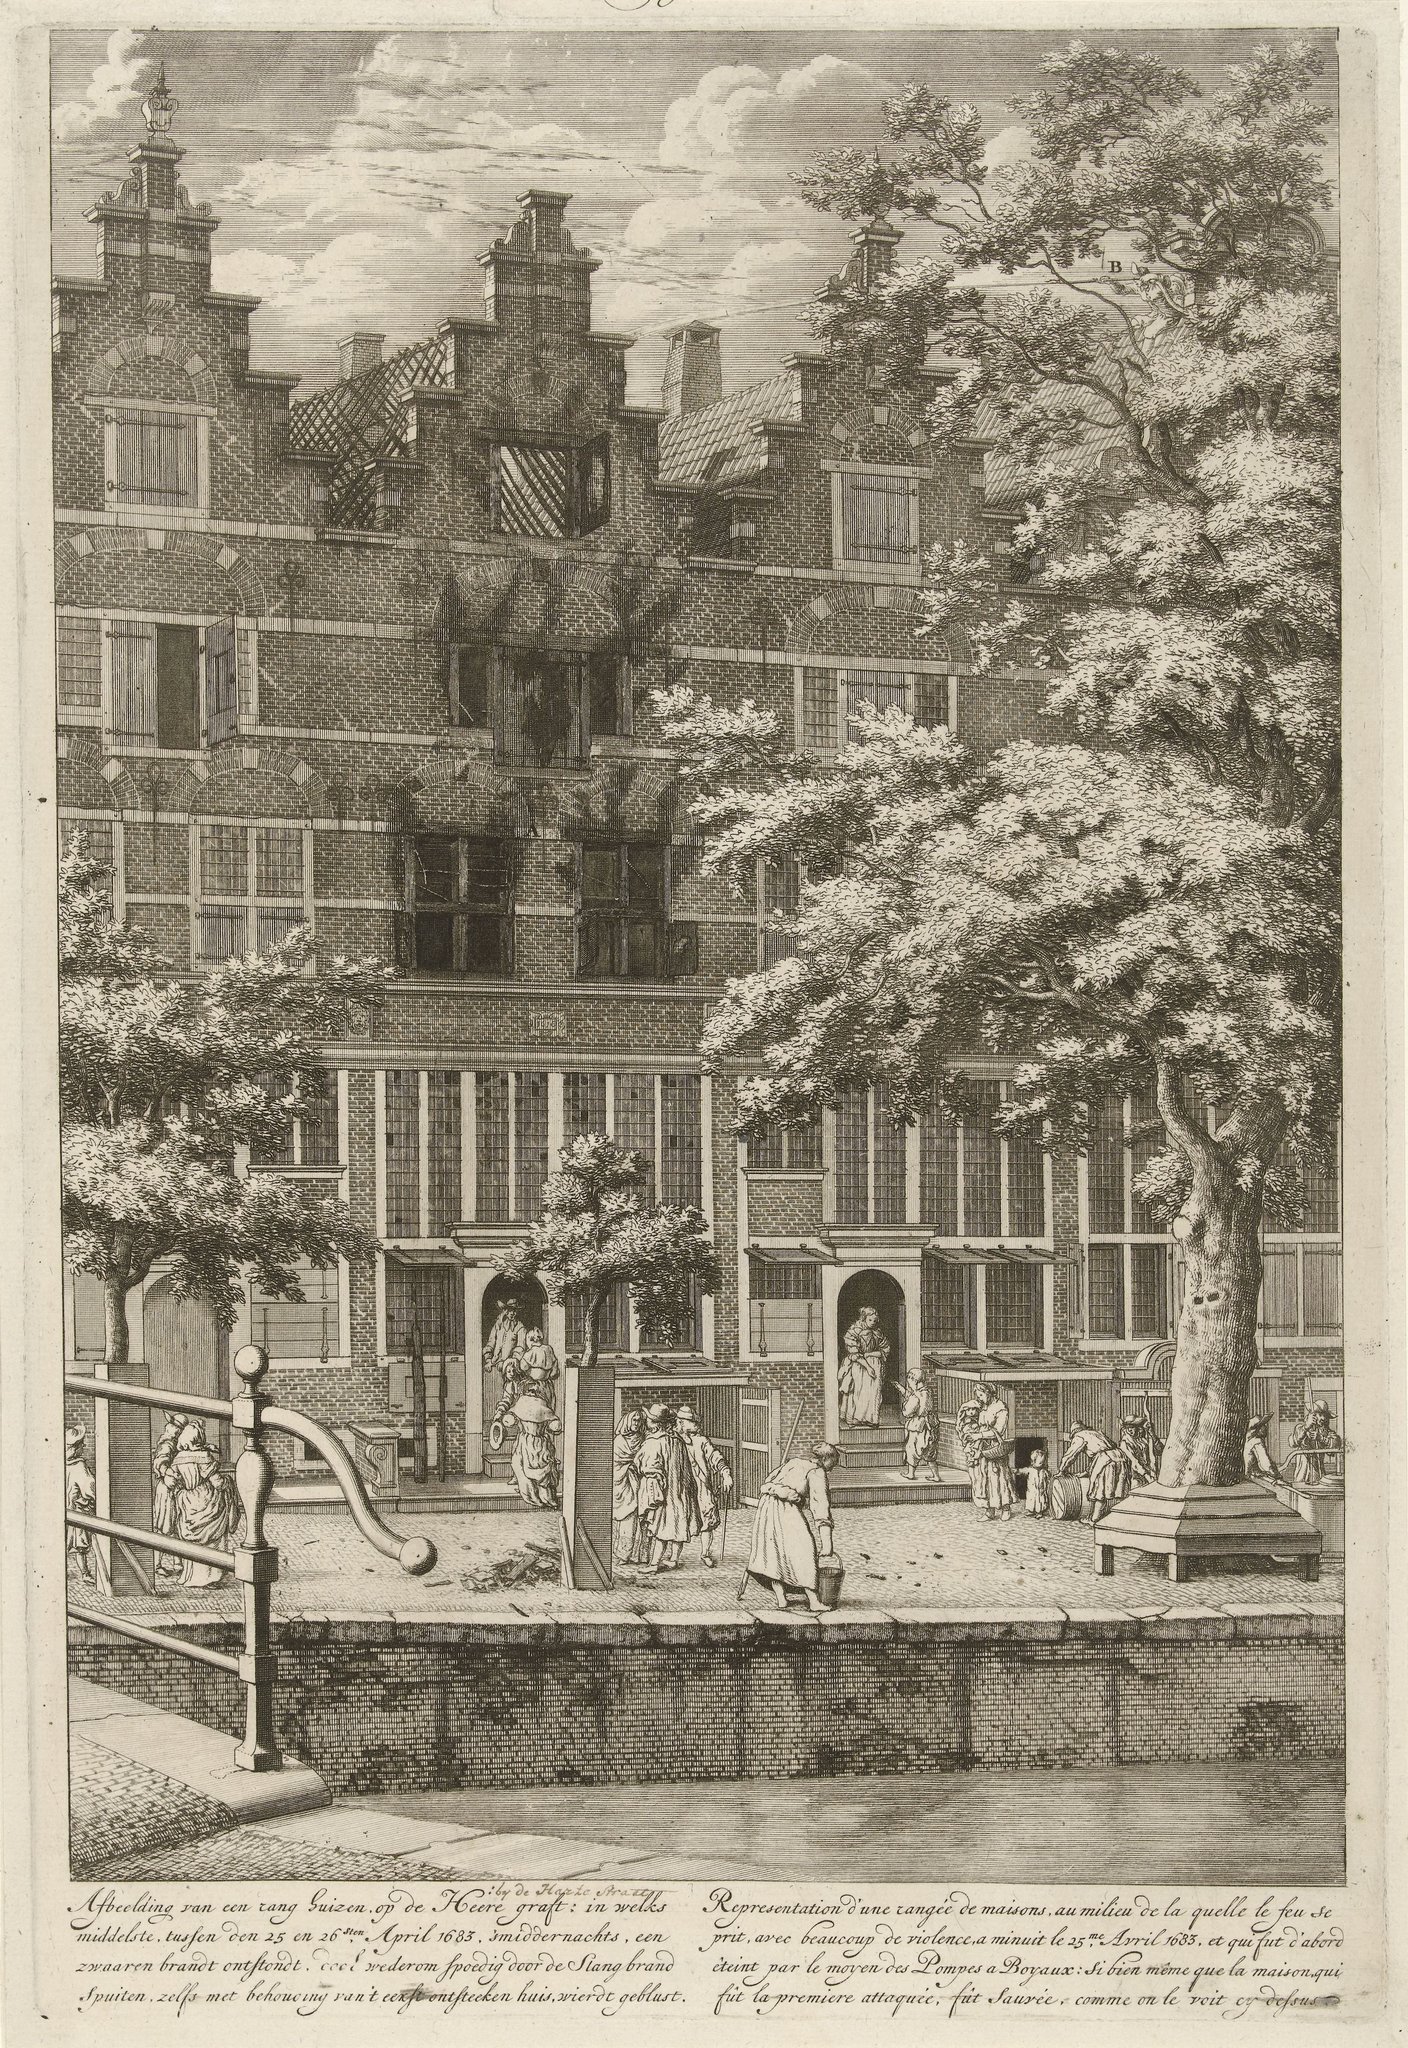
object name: book illustration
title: Uitgebrand huis op de Herengracht, 1683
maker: jan van der heyden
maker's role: draughtsman, painter, print maker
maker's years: 1637-1712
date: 1690-1735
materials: paper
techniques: engraving, etching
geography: amsterdam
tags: amsterdam, painter, print maker, draughtsman, jan van der heyden, urban housing, ruin of a building ~ architecture, canals, waters (in city), fire-fighting, fire-extinguishing equipment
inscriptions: inscription: ‘;bij de Harte Straat’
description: Prent ook gebruikt in: Heyden, Jan van der. Beschryving der nieuwlyks uitgevonden en geoctrojeerde slang-brand-spuiten en haare wyze van brand-blussen, tegenwoordig binnen Amsterdam in gebruik zijnde (…). 1e druk. Amsterdam: Jan Rieuwertsz. (II), 1690. En in: Heyden, Jan van der. Beschryving der nieuwlyks uitgevonden en geoctrojeerde slang-brand-spuiten en haare wyze van brand-blussen, tegenwoordig binnen Amsterdam in gebruik zijnde (…). 2e druk. Amsterdam: erfgenamen Jan van der Heyden, 1735. Voor eerdere staat (voor de letter) zieRP-P-1944-232.